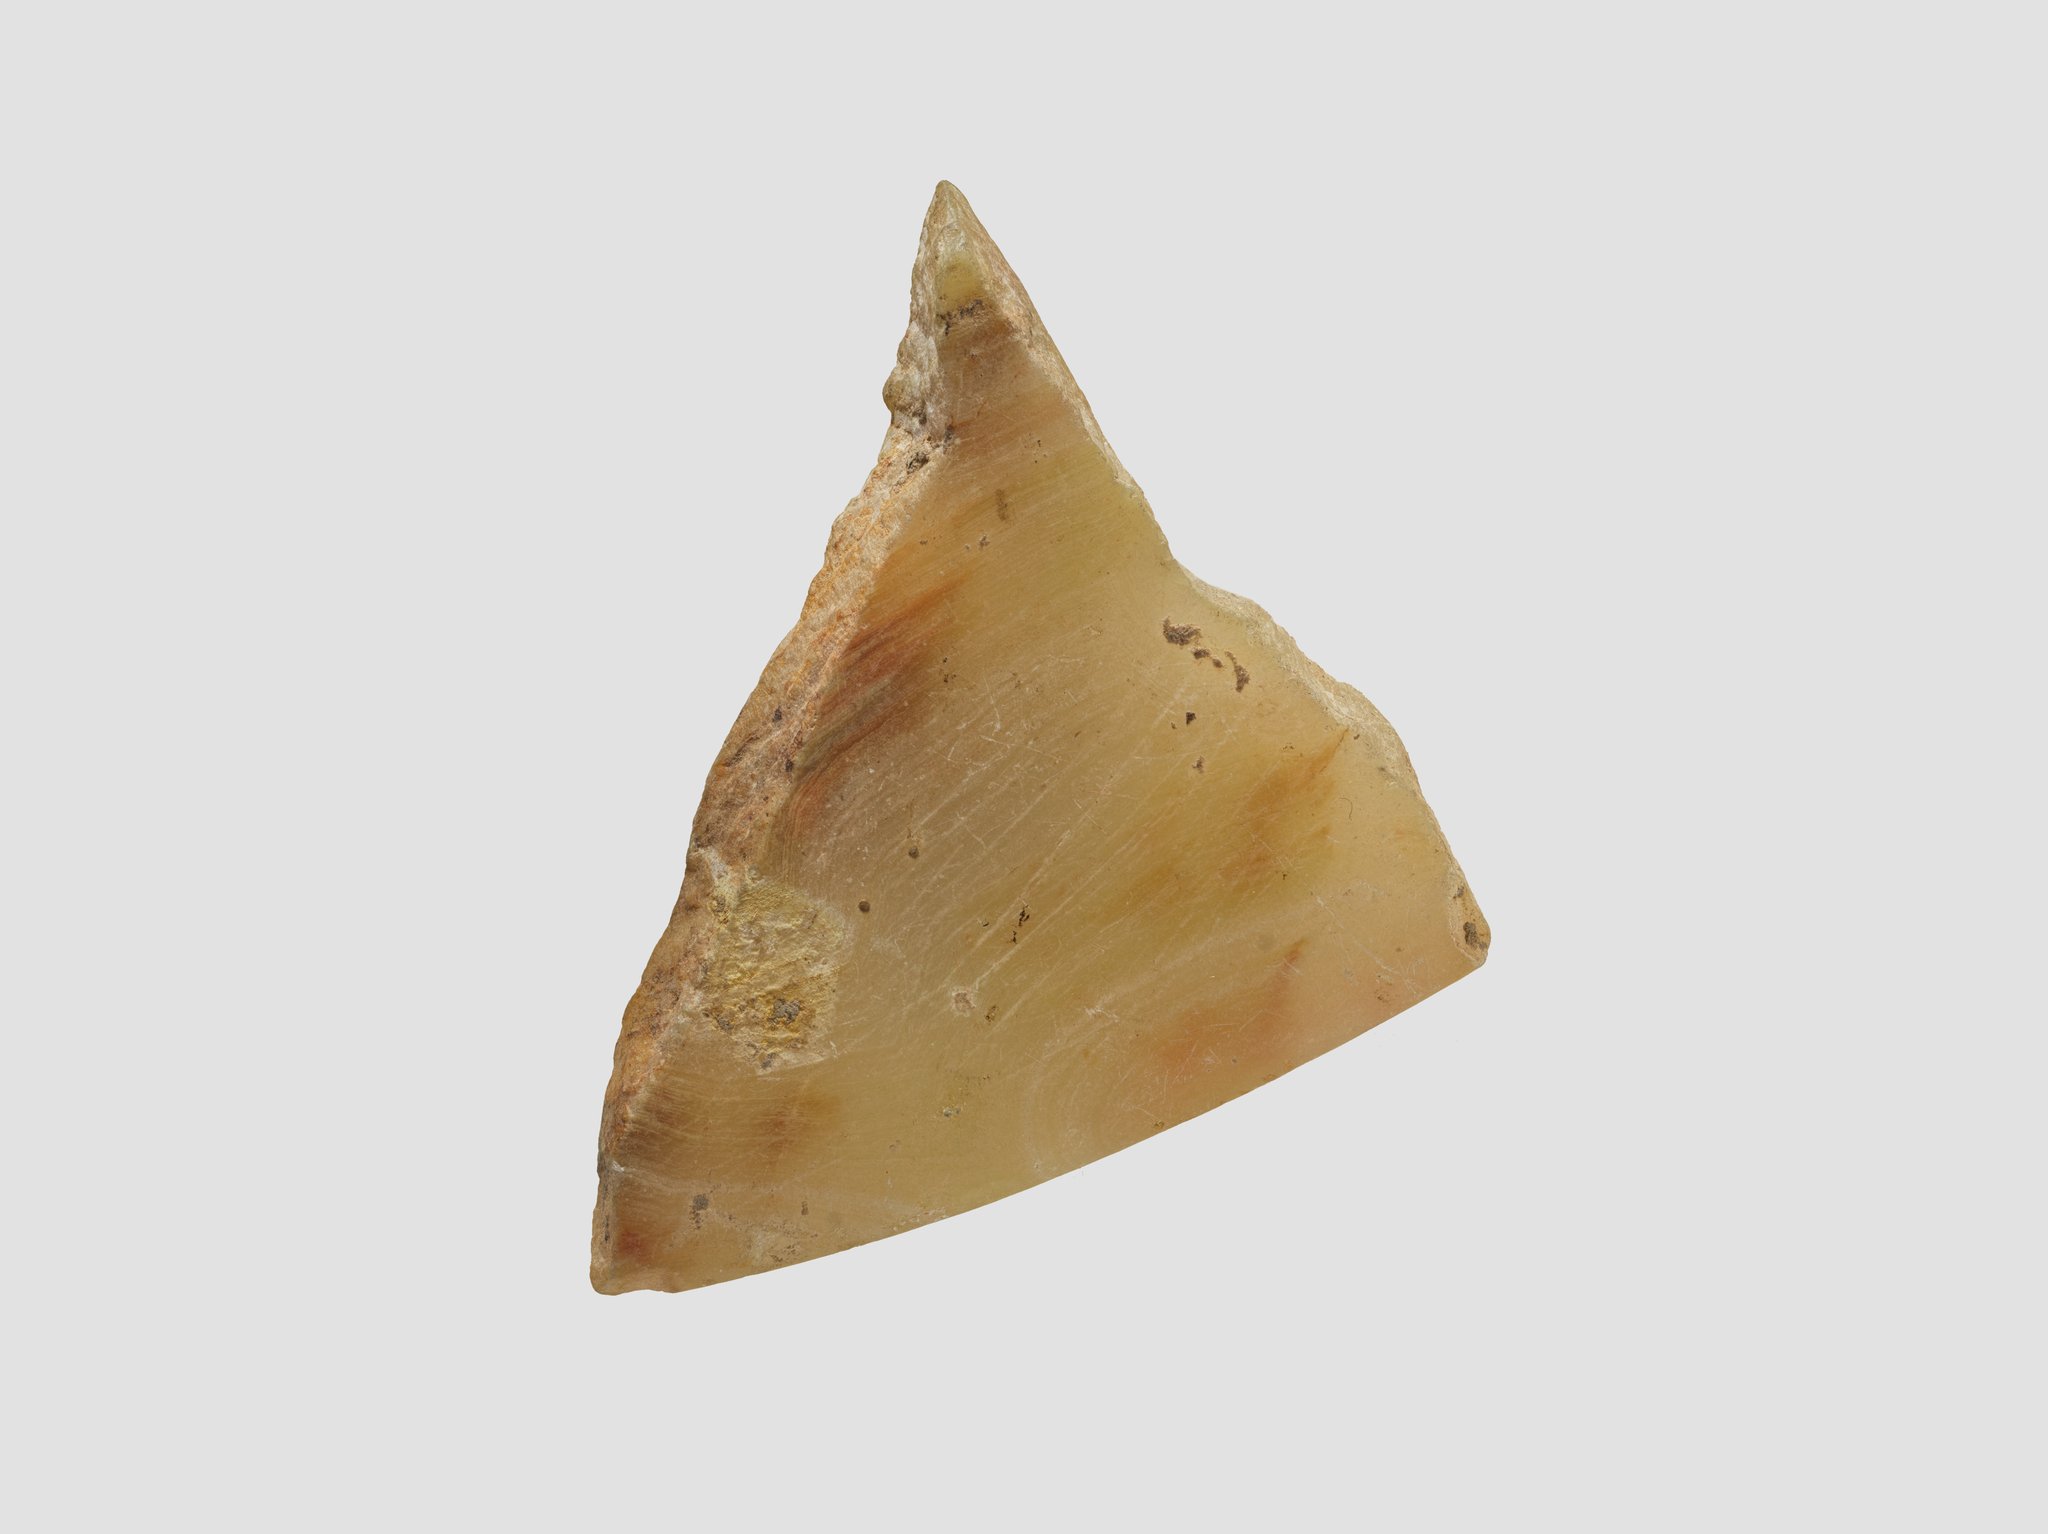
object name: stone vessel fragment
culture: iranian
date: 5000-2001 BCE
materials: alabaster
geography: iran